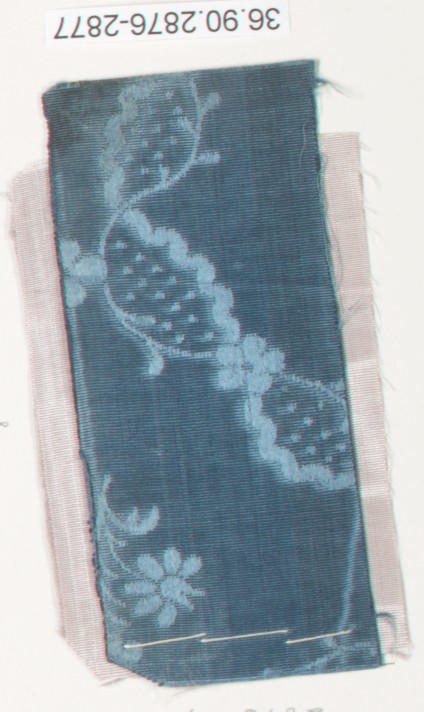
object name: piece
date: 1801-1900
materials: silk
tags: flowers